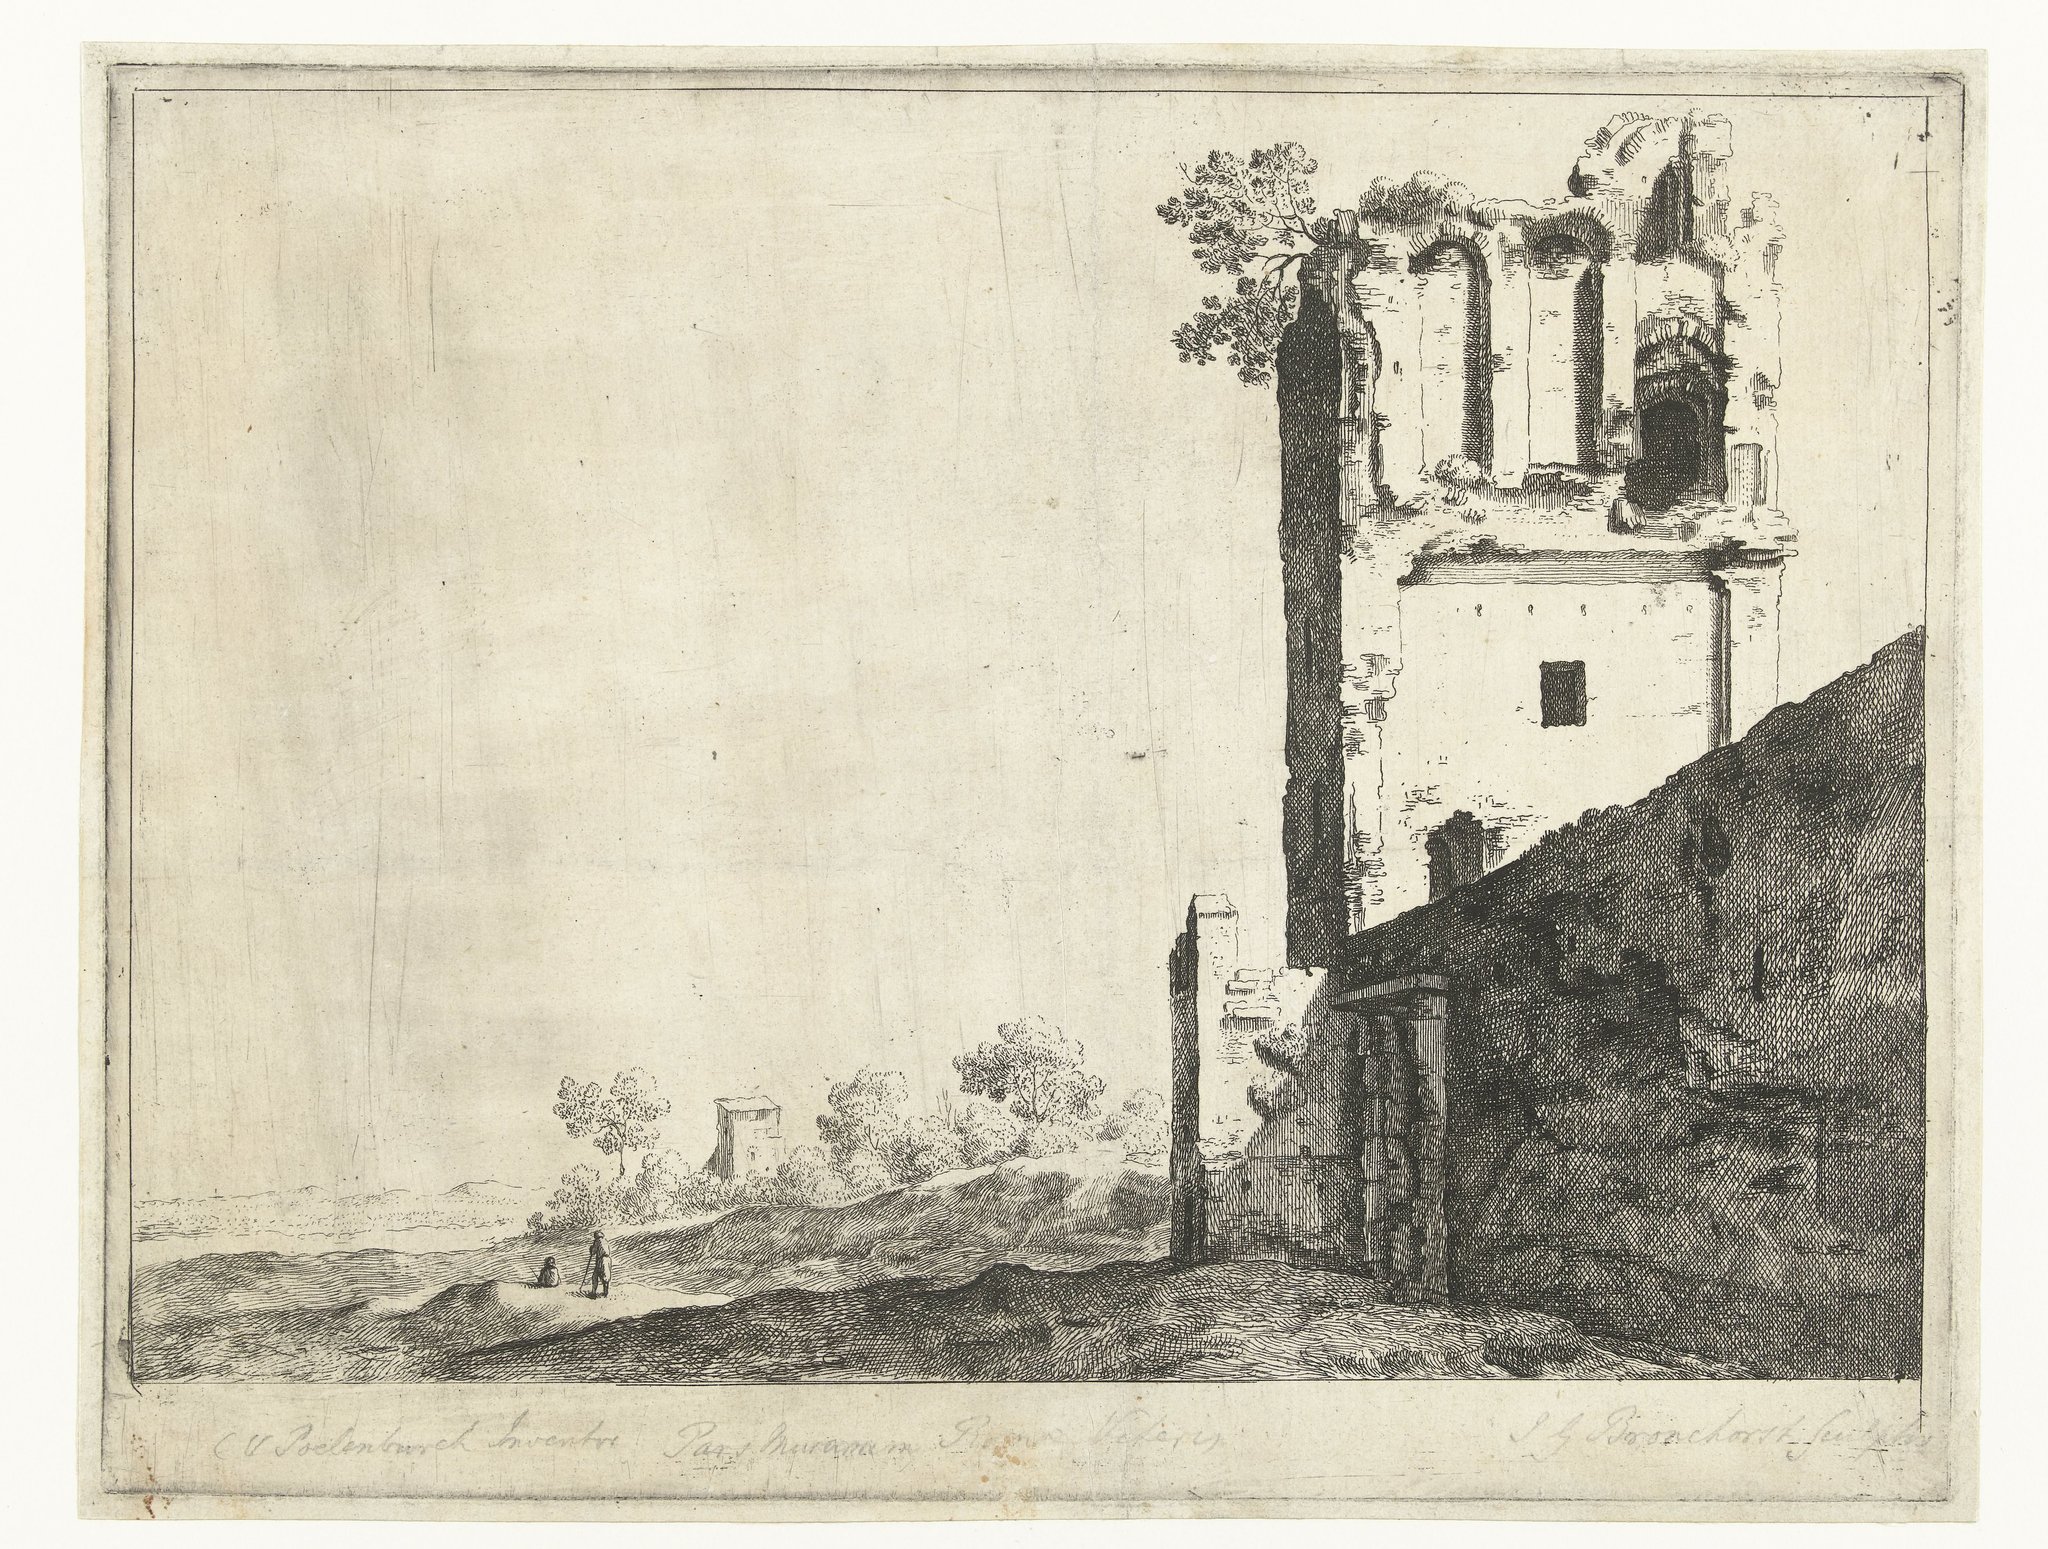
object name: print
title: Ruïnes in Rome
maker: jan gerritsz. van bronckhorst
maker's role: draughtsman, painter, print maker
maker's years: 1603-1661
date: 1613-1661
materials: paper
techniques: etching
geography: netherlands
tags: ruin of a building ~ architecture, landscape with ruins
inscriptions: collector's mark: Lugt 2228, collector's mark: Lugt 2760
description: Herkomst Collectie Spencer Churchill. Prent naar ontwerp van Cornelis van Poelenburch. Prent uit serie van negen prenten met Romeinse ruïnes.